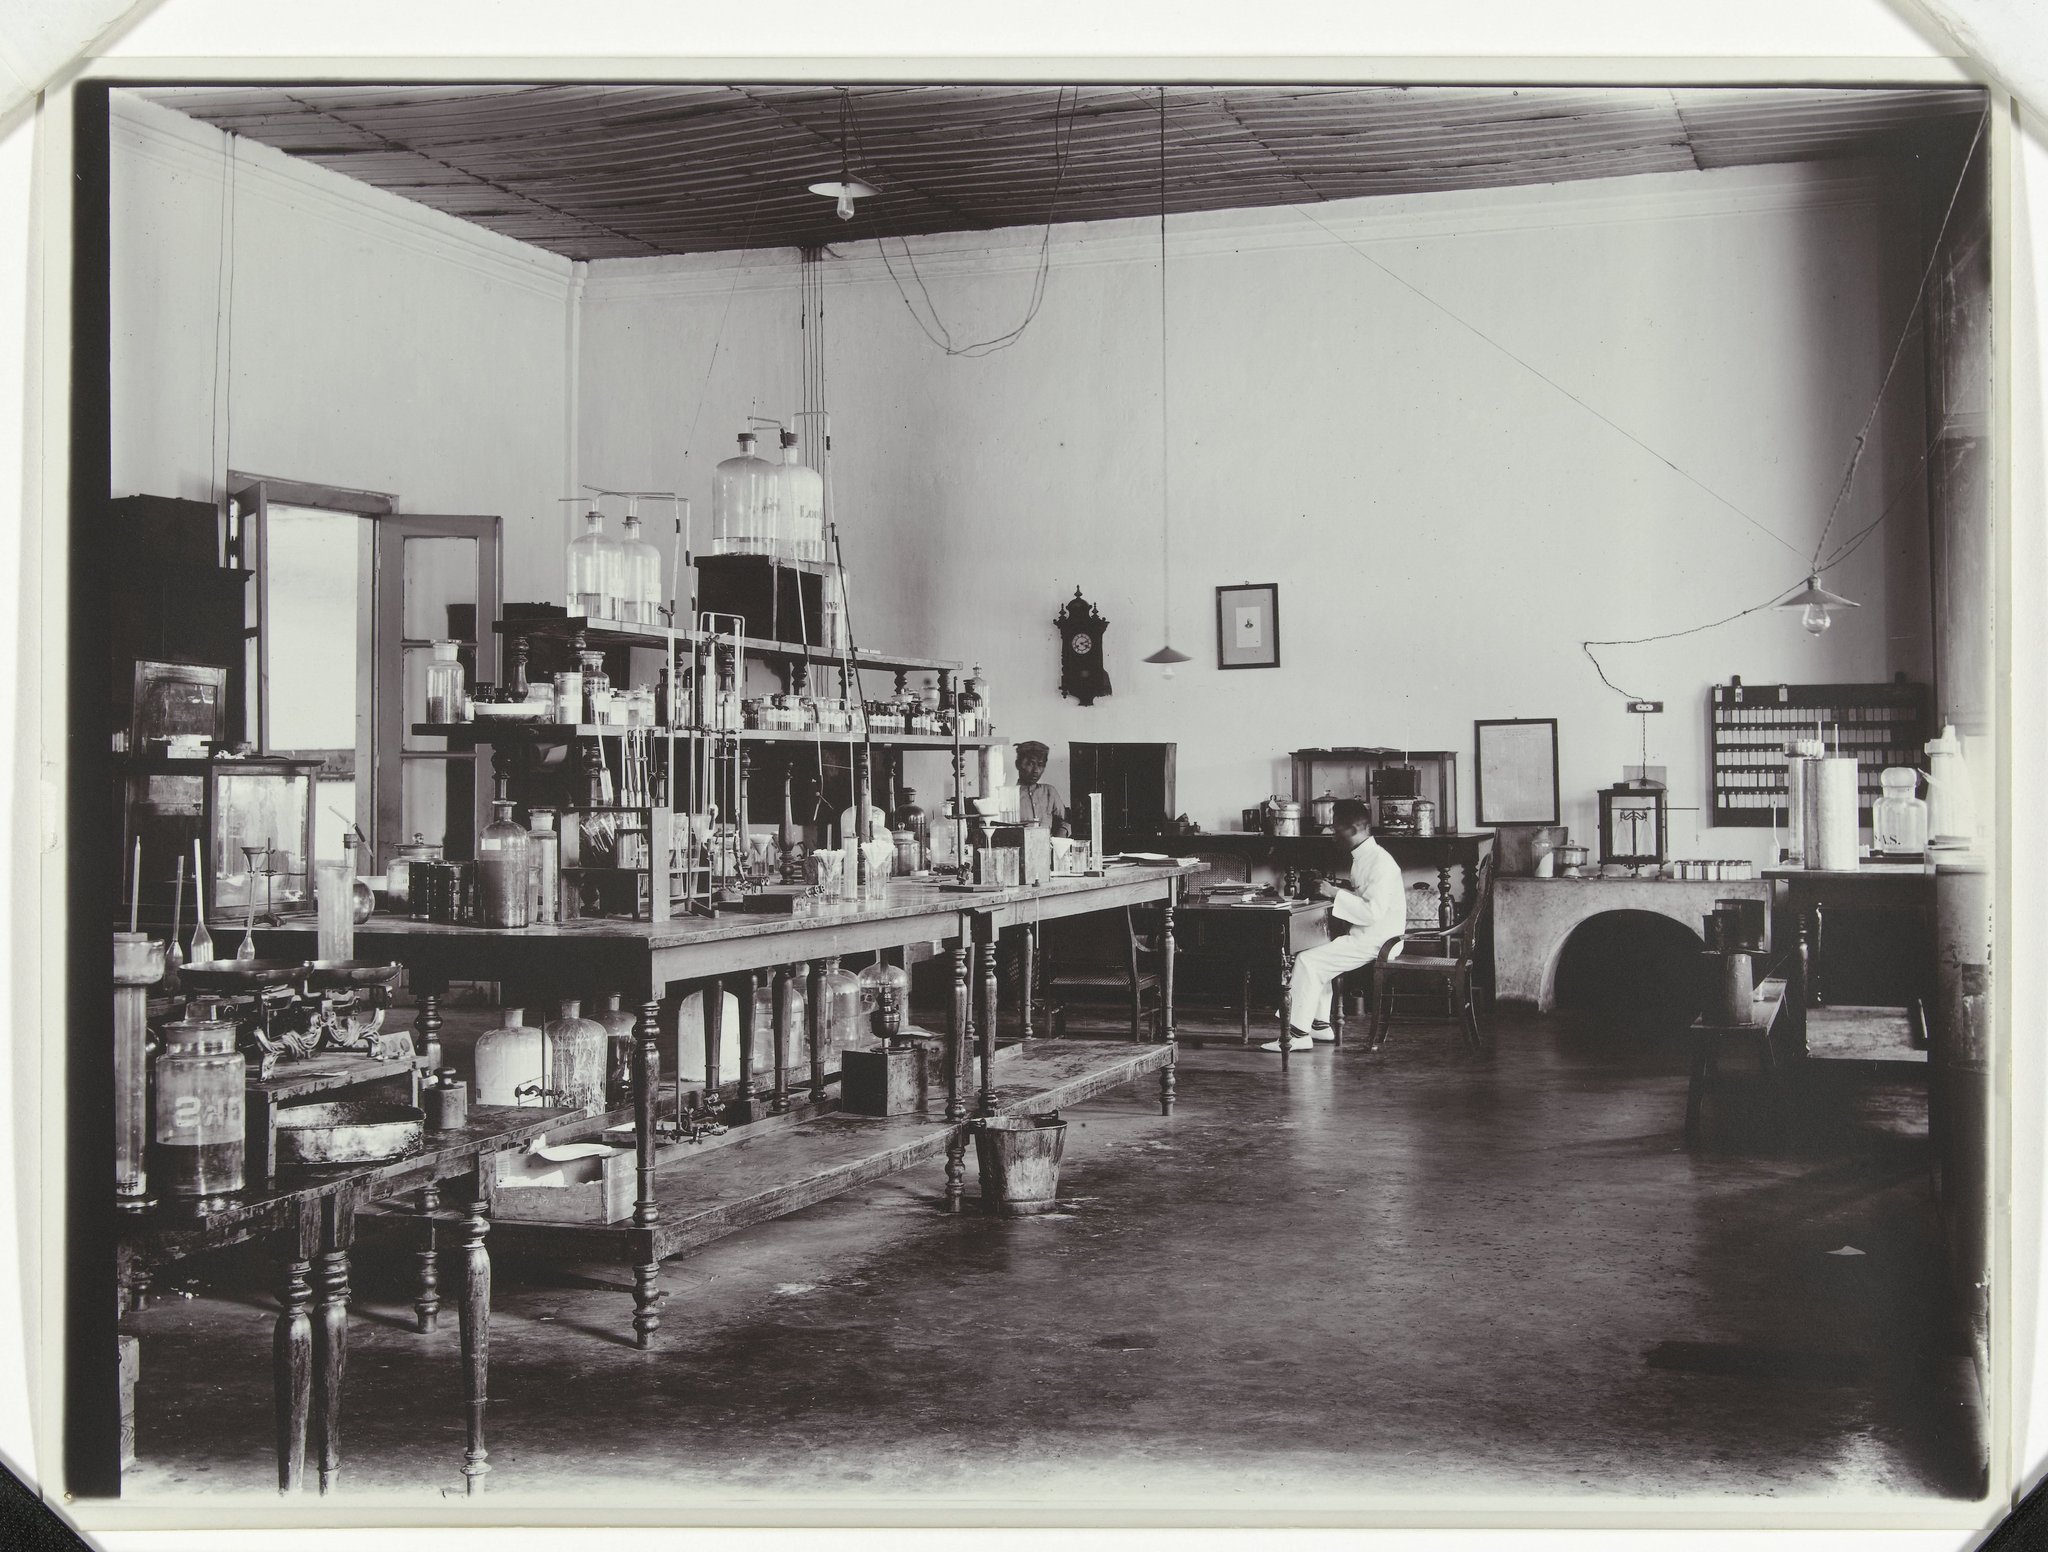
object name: photograph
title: Interieur van het laboratorium van de suikeronderneming Nieuw Tersana, Cheribon, voormalig Nederlands-Indië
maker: onnes kurkdjian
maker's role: fotograaf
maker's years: 1851-1903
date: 1890-1935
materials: paper, photographic support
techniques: gelatin silver print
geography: dutch east indies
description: Interieur van het laboratorium van de suikeronderneming Nieuw Tersana, Cheribon, voormalig Nederlands-Indië